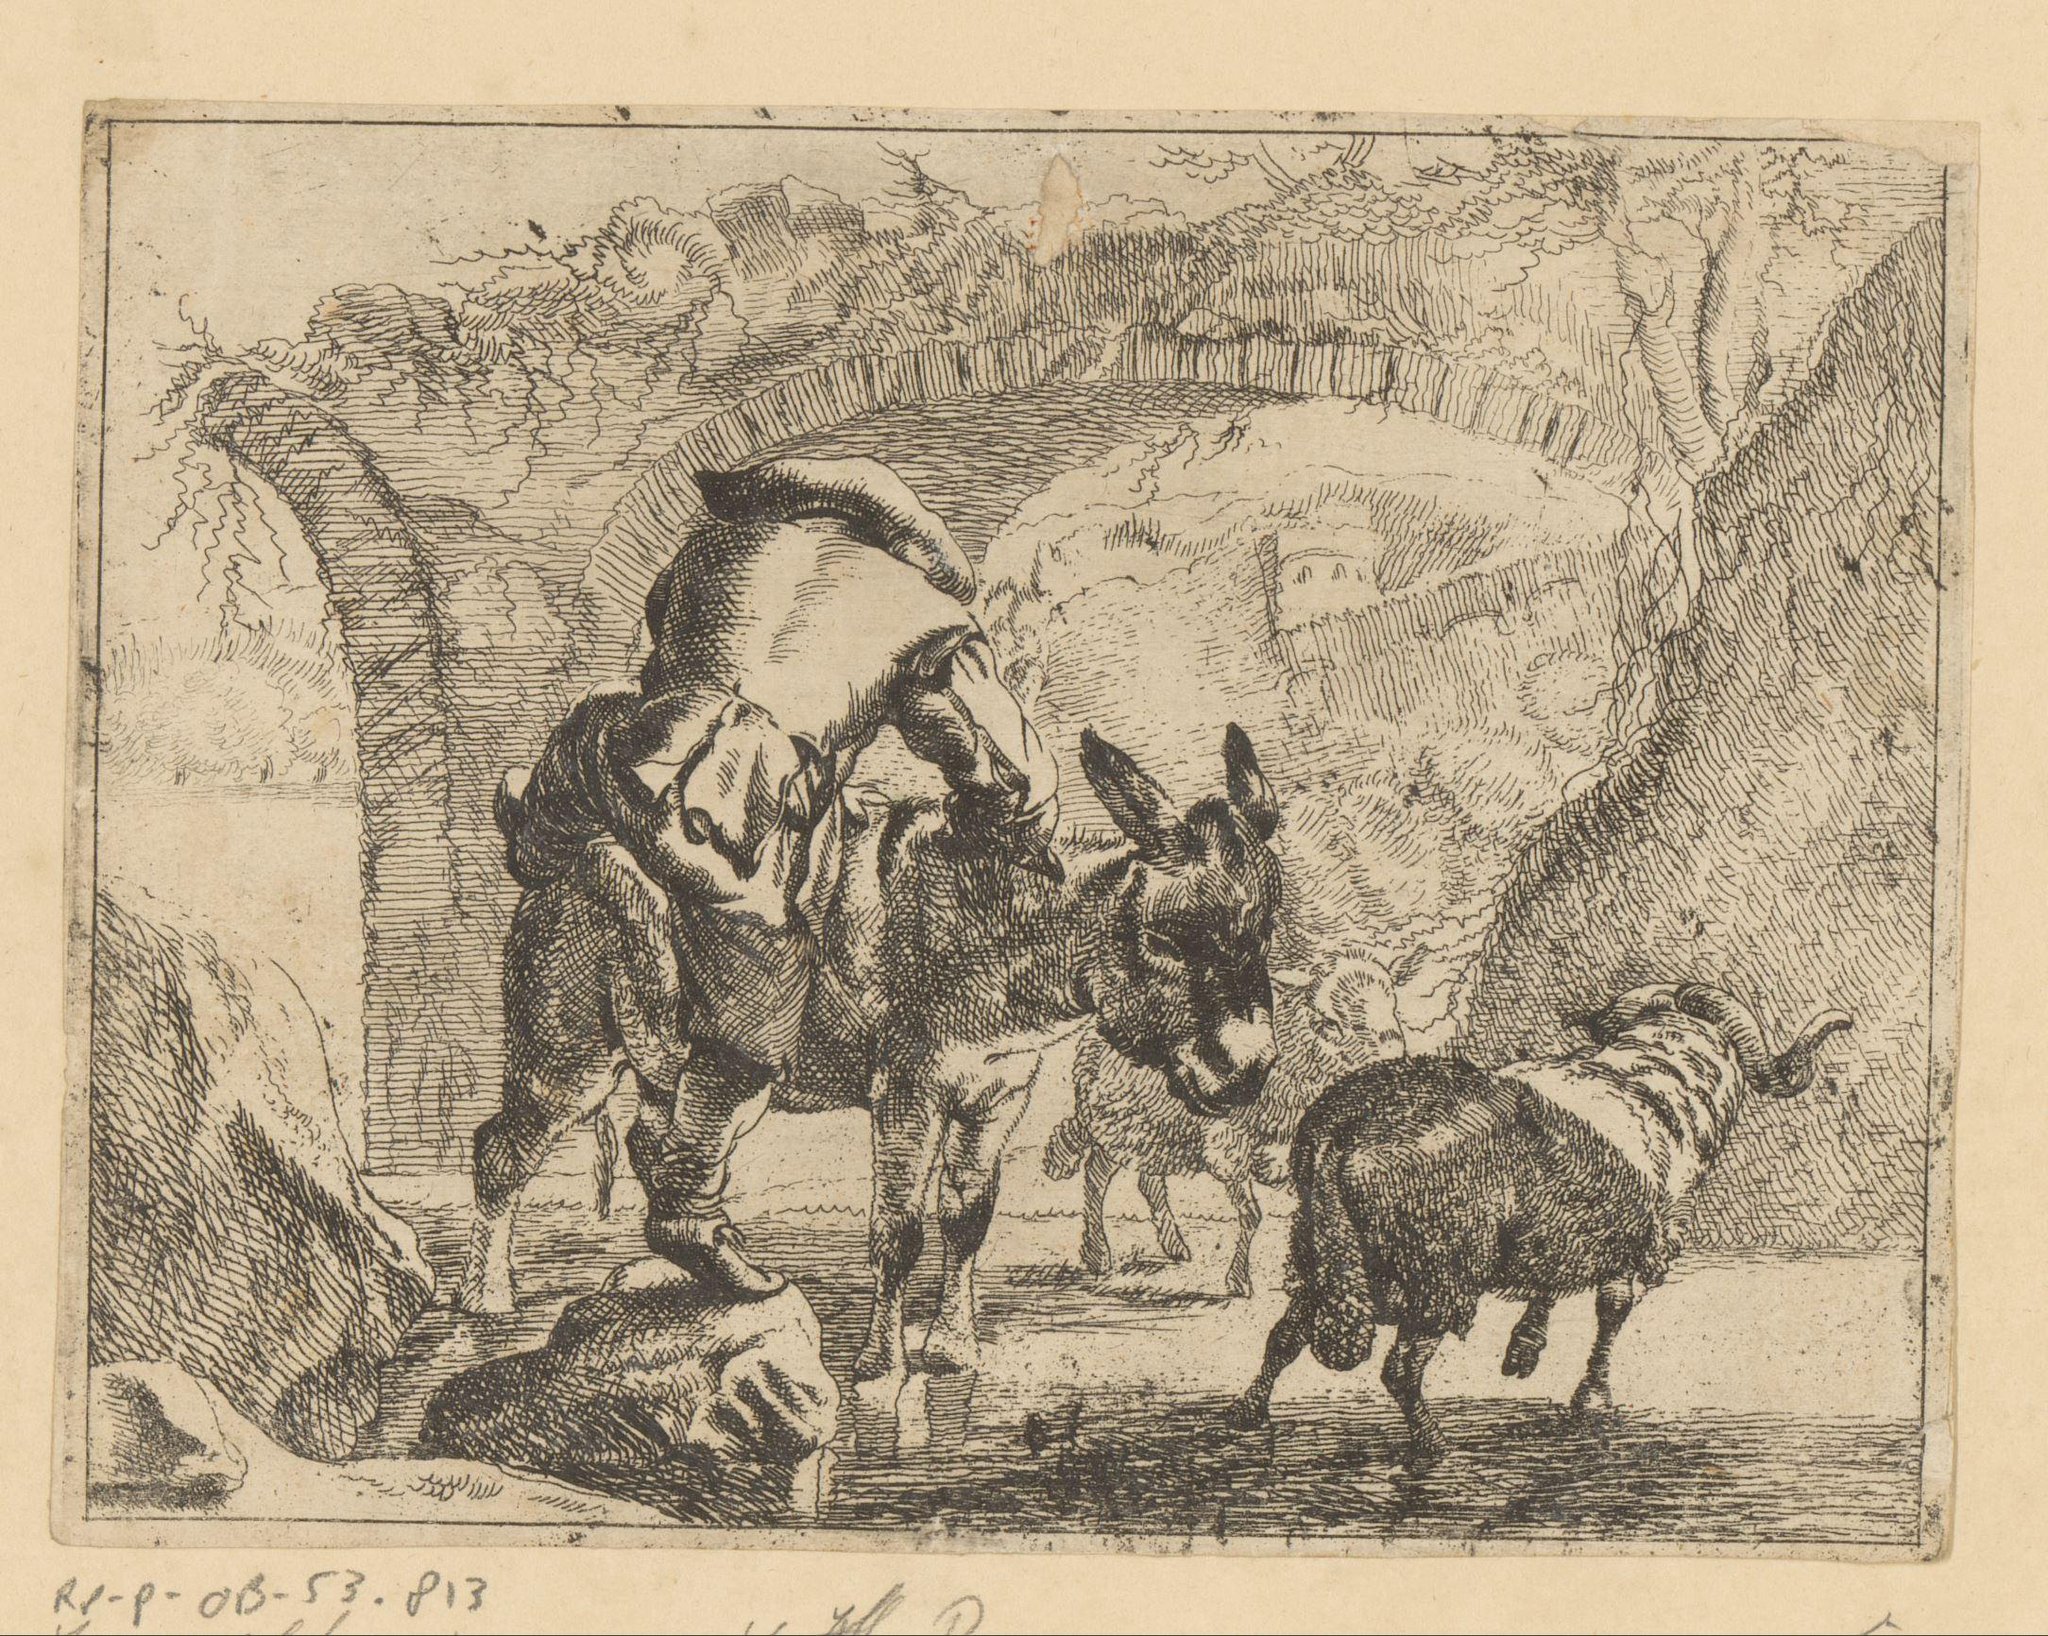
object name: print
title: Man vanaf een steen op rug van een ezel stappend bij ruïnes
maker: johann heinrich roos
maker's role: draughtsman, print maker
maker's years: 1631-1685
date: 1641-1685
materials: paper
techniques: etching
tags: riding a horse, ass, or mule; rider, horseman, ass, donkey, ram, landscape with ruins, sheep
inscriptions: collector's mark: Lugt 2228